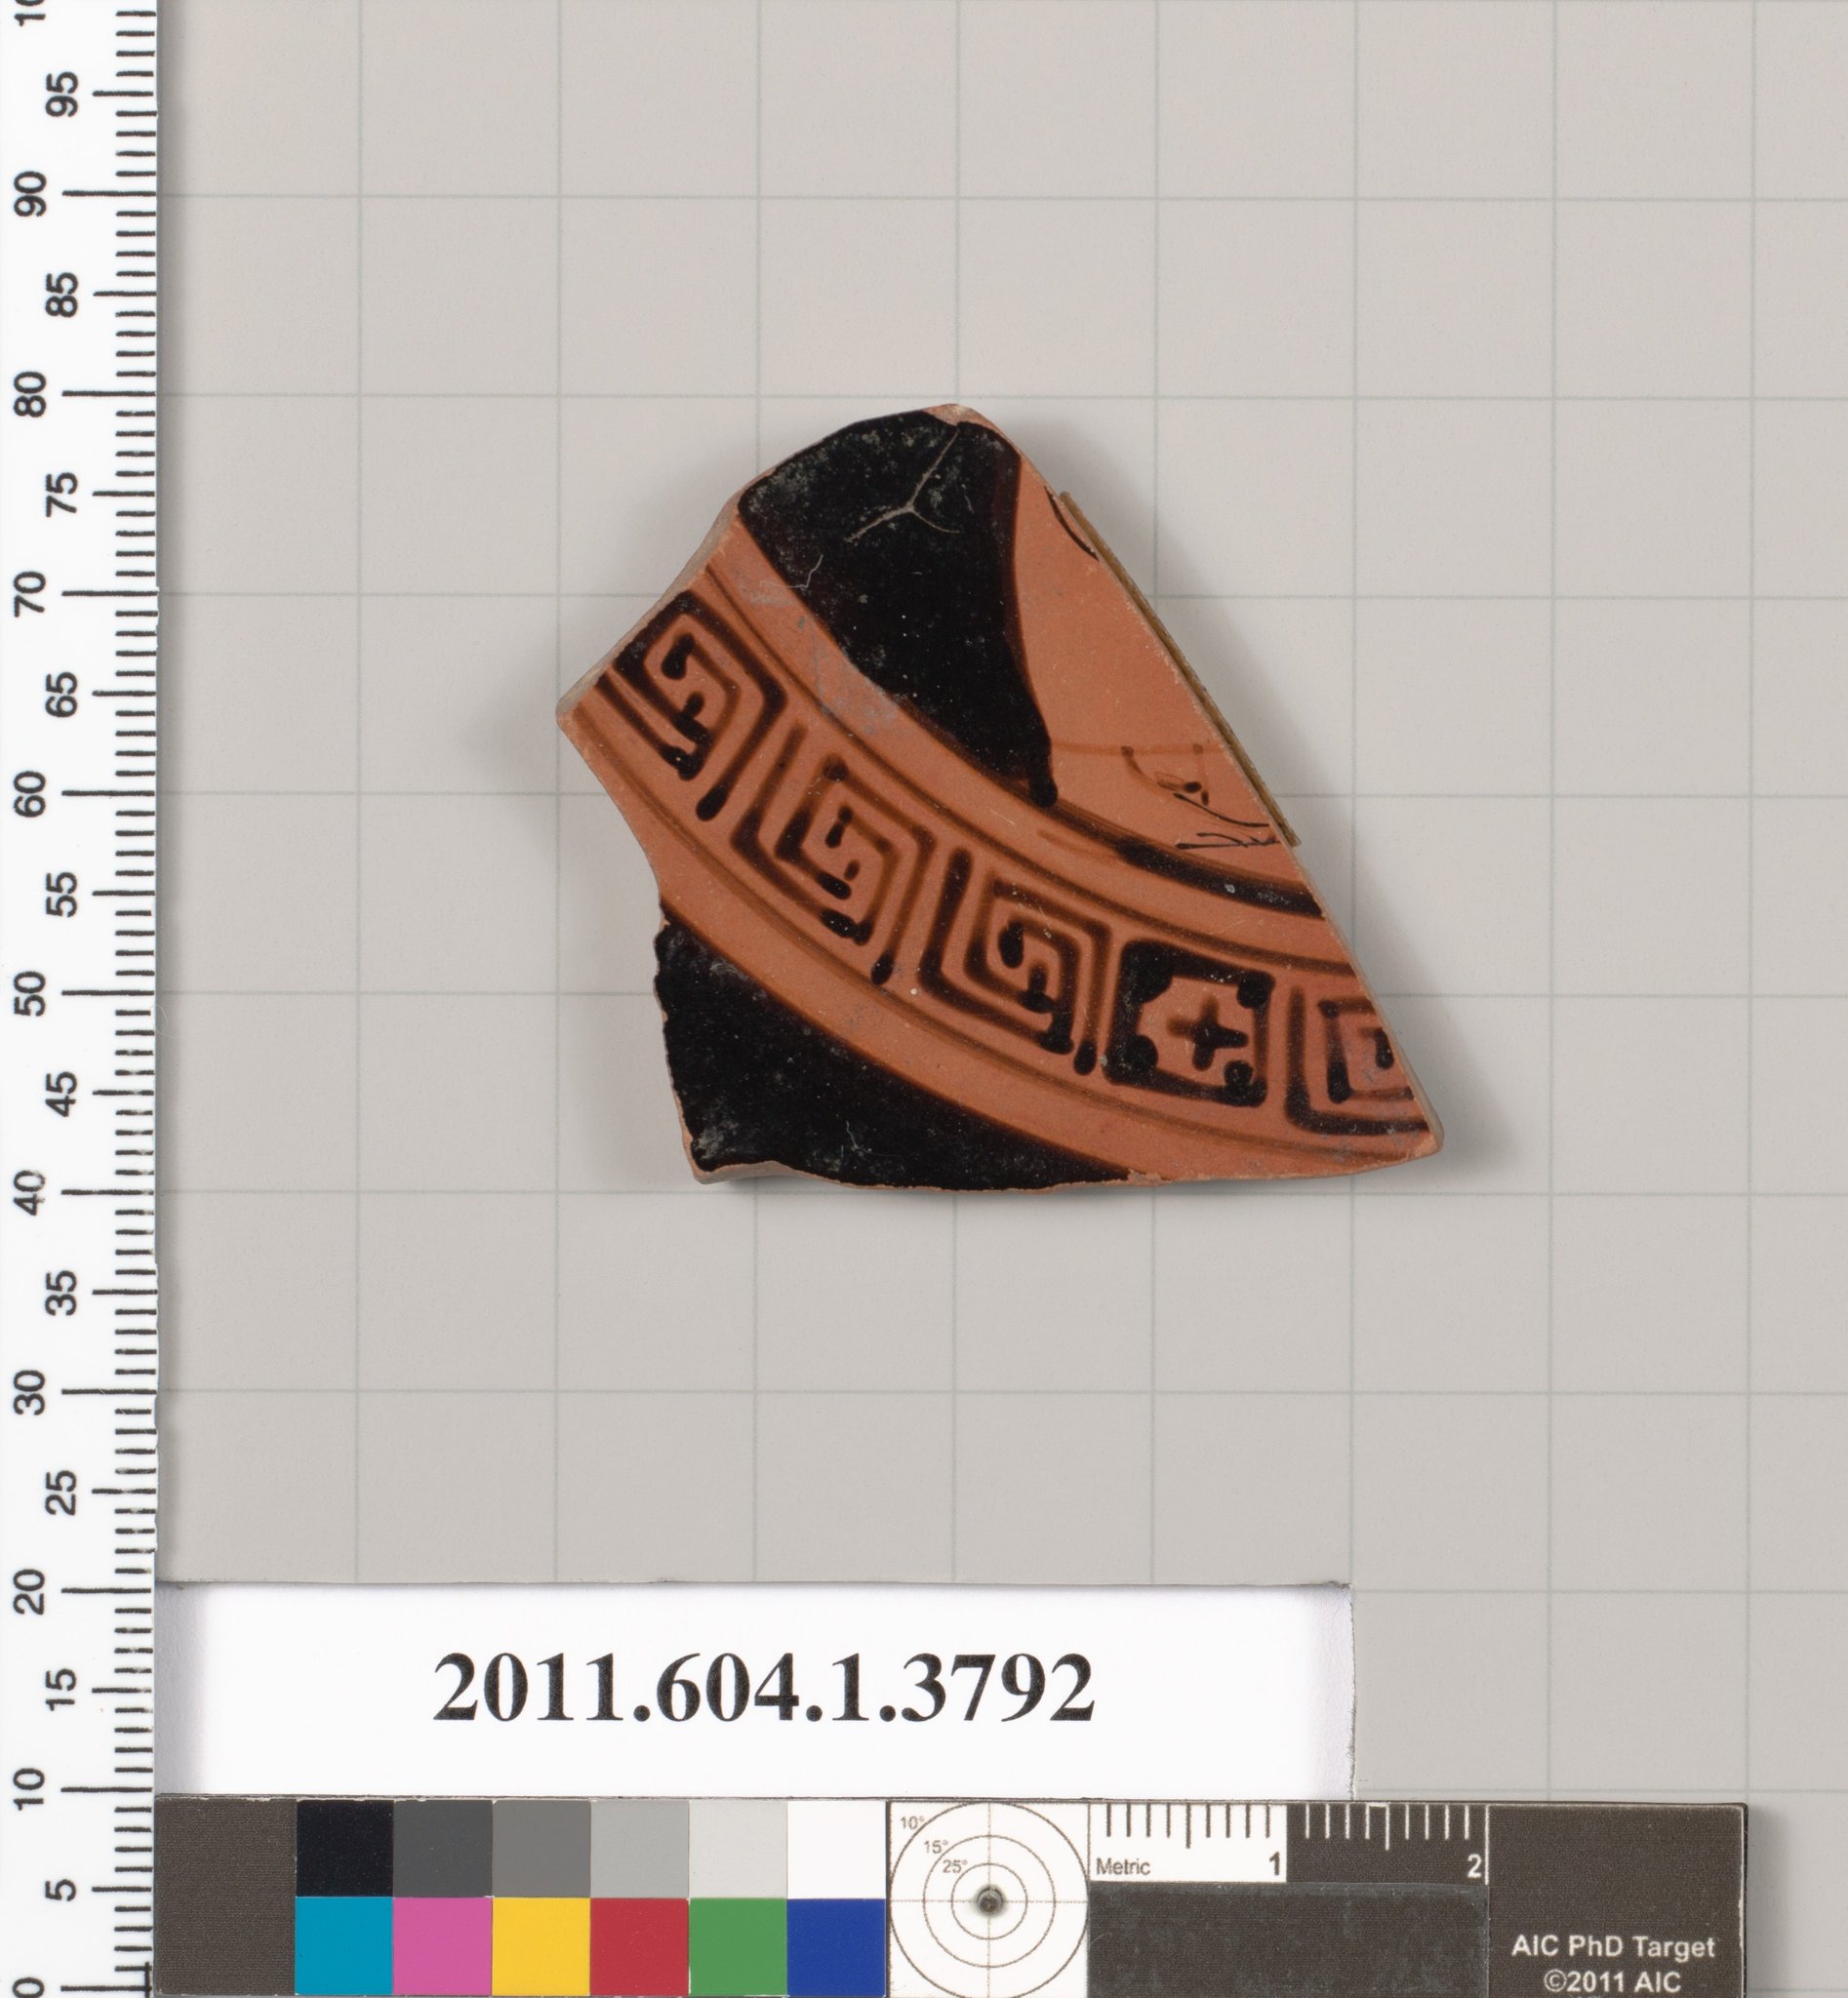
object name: kylix fragment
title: Terracotta fragment of a kylix (drinking cup)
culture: greek, attic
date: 475-451 BCE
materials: terracotta